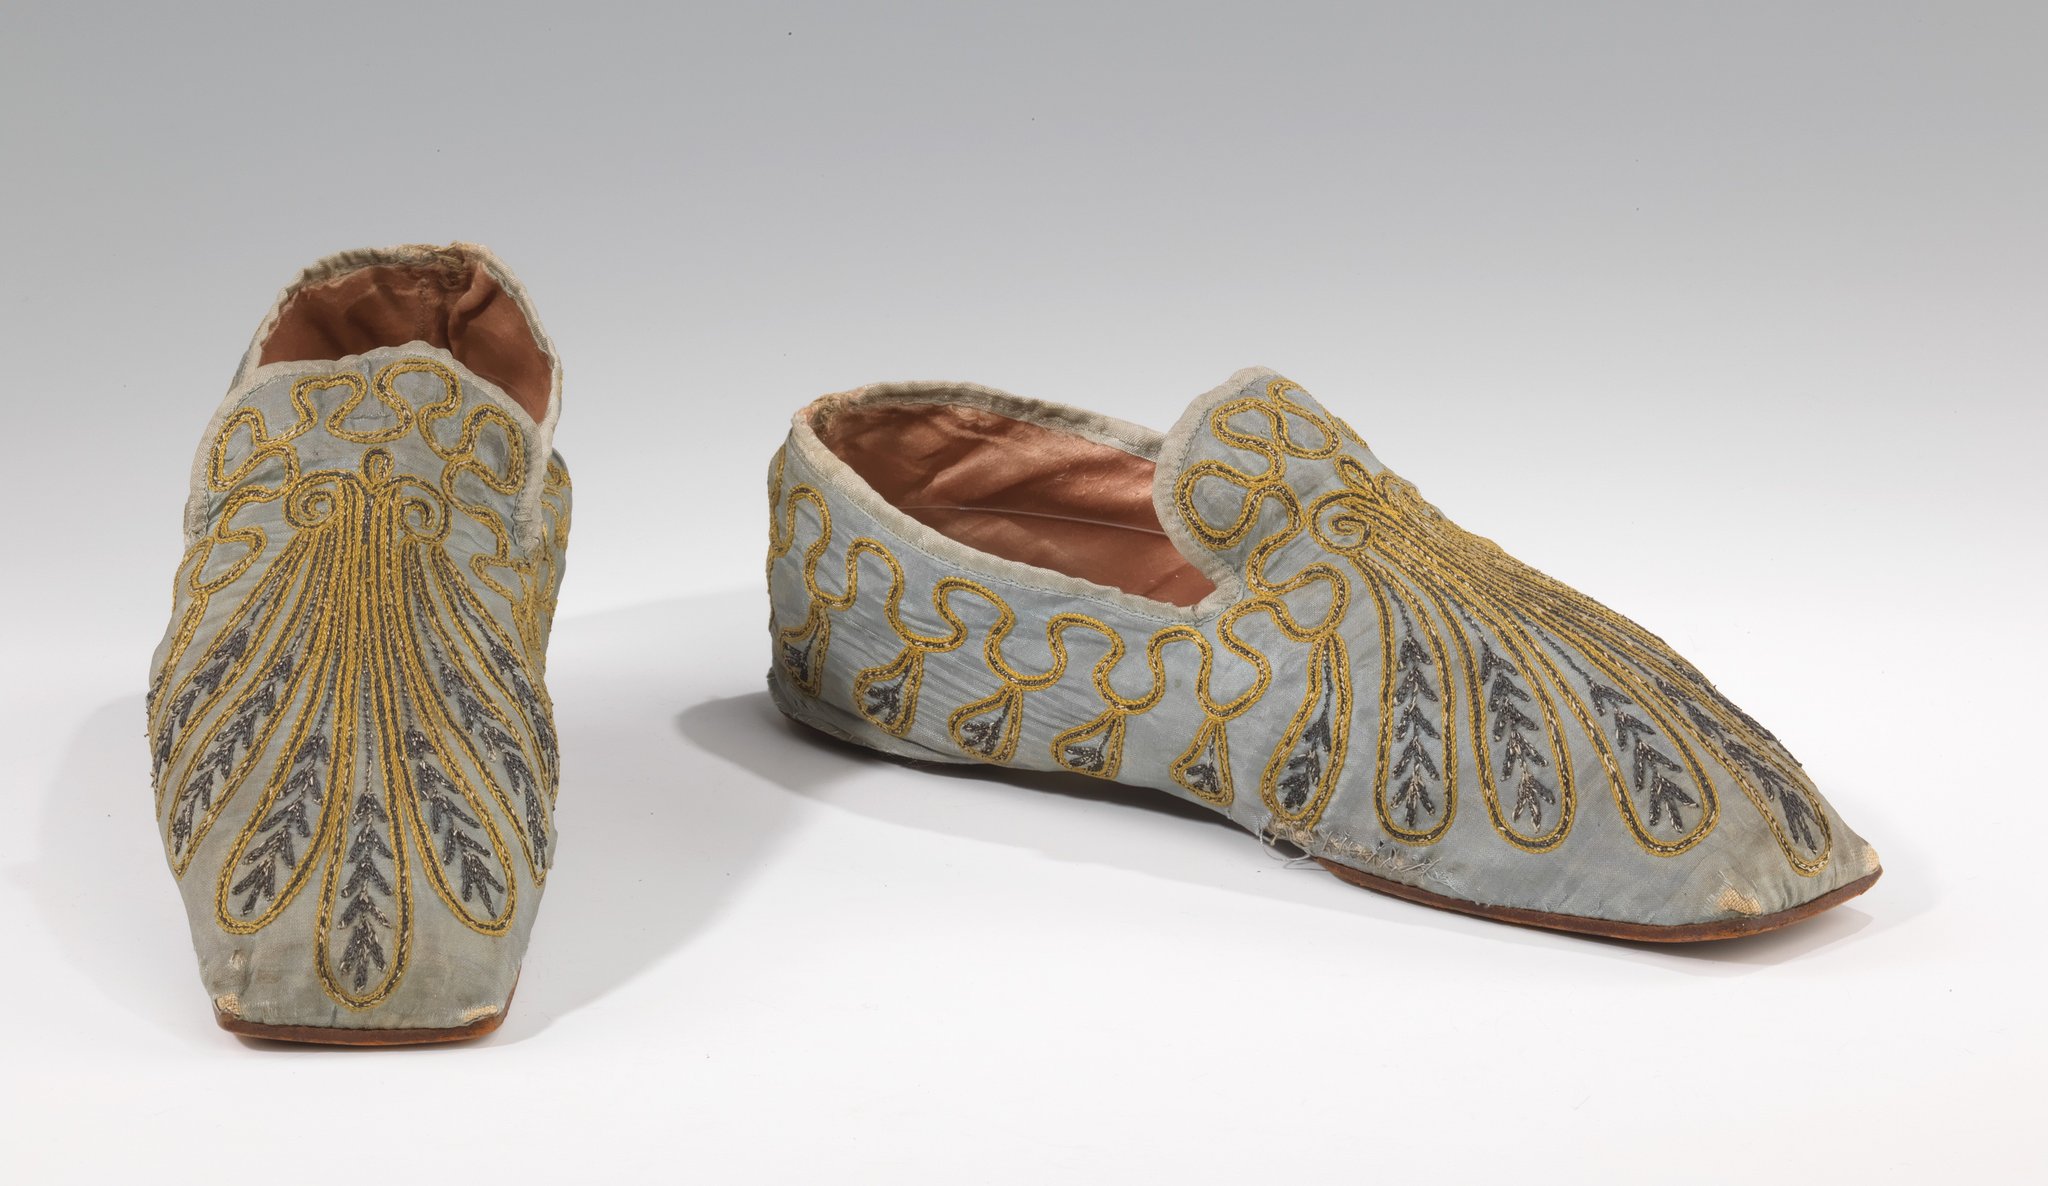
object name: slipper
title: Slippers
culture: french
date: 1835-1845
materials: silk